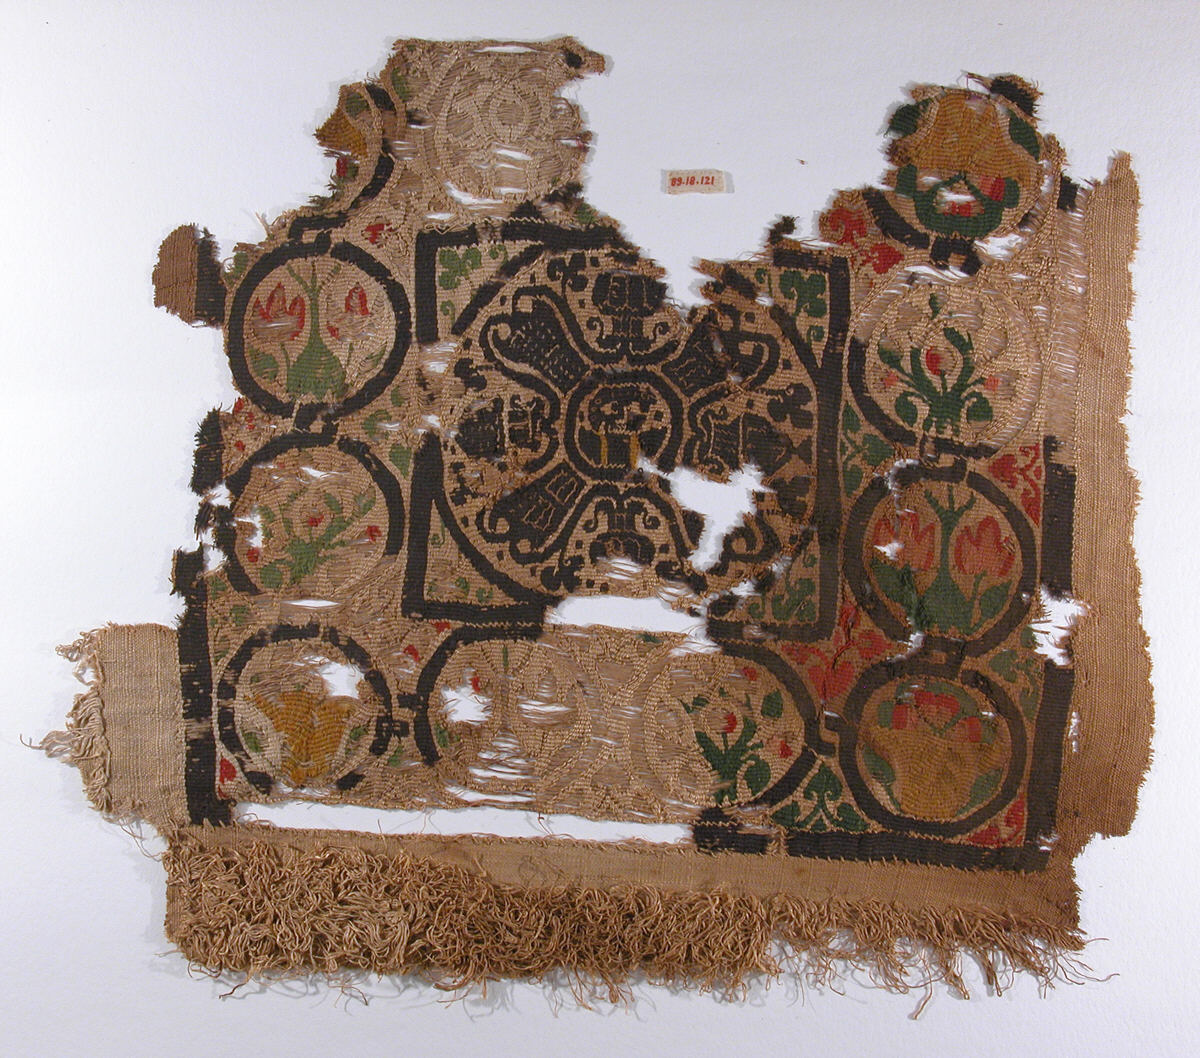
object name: textile fragment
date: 301-400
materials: linen, wool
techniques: weave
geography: egypt